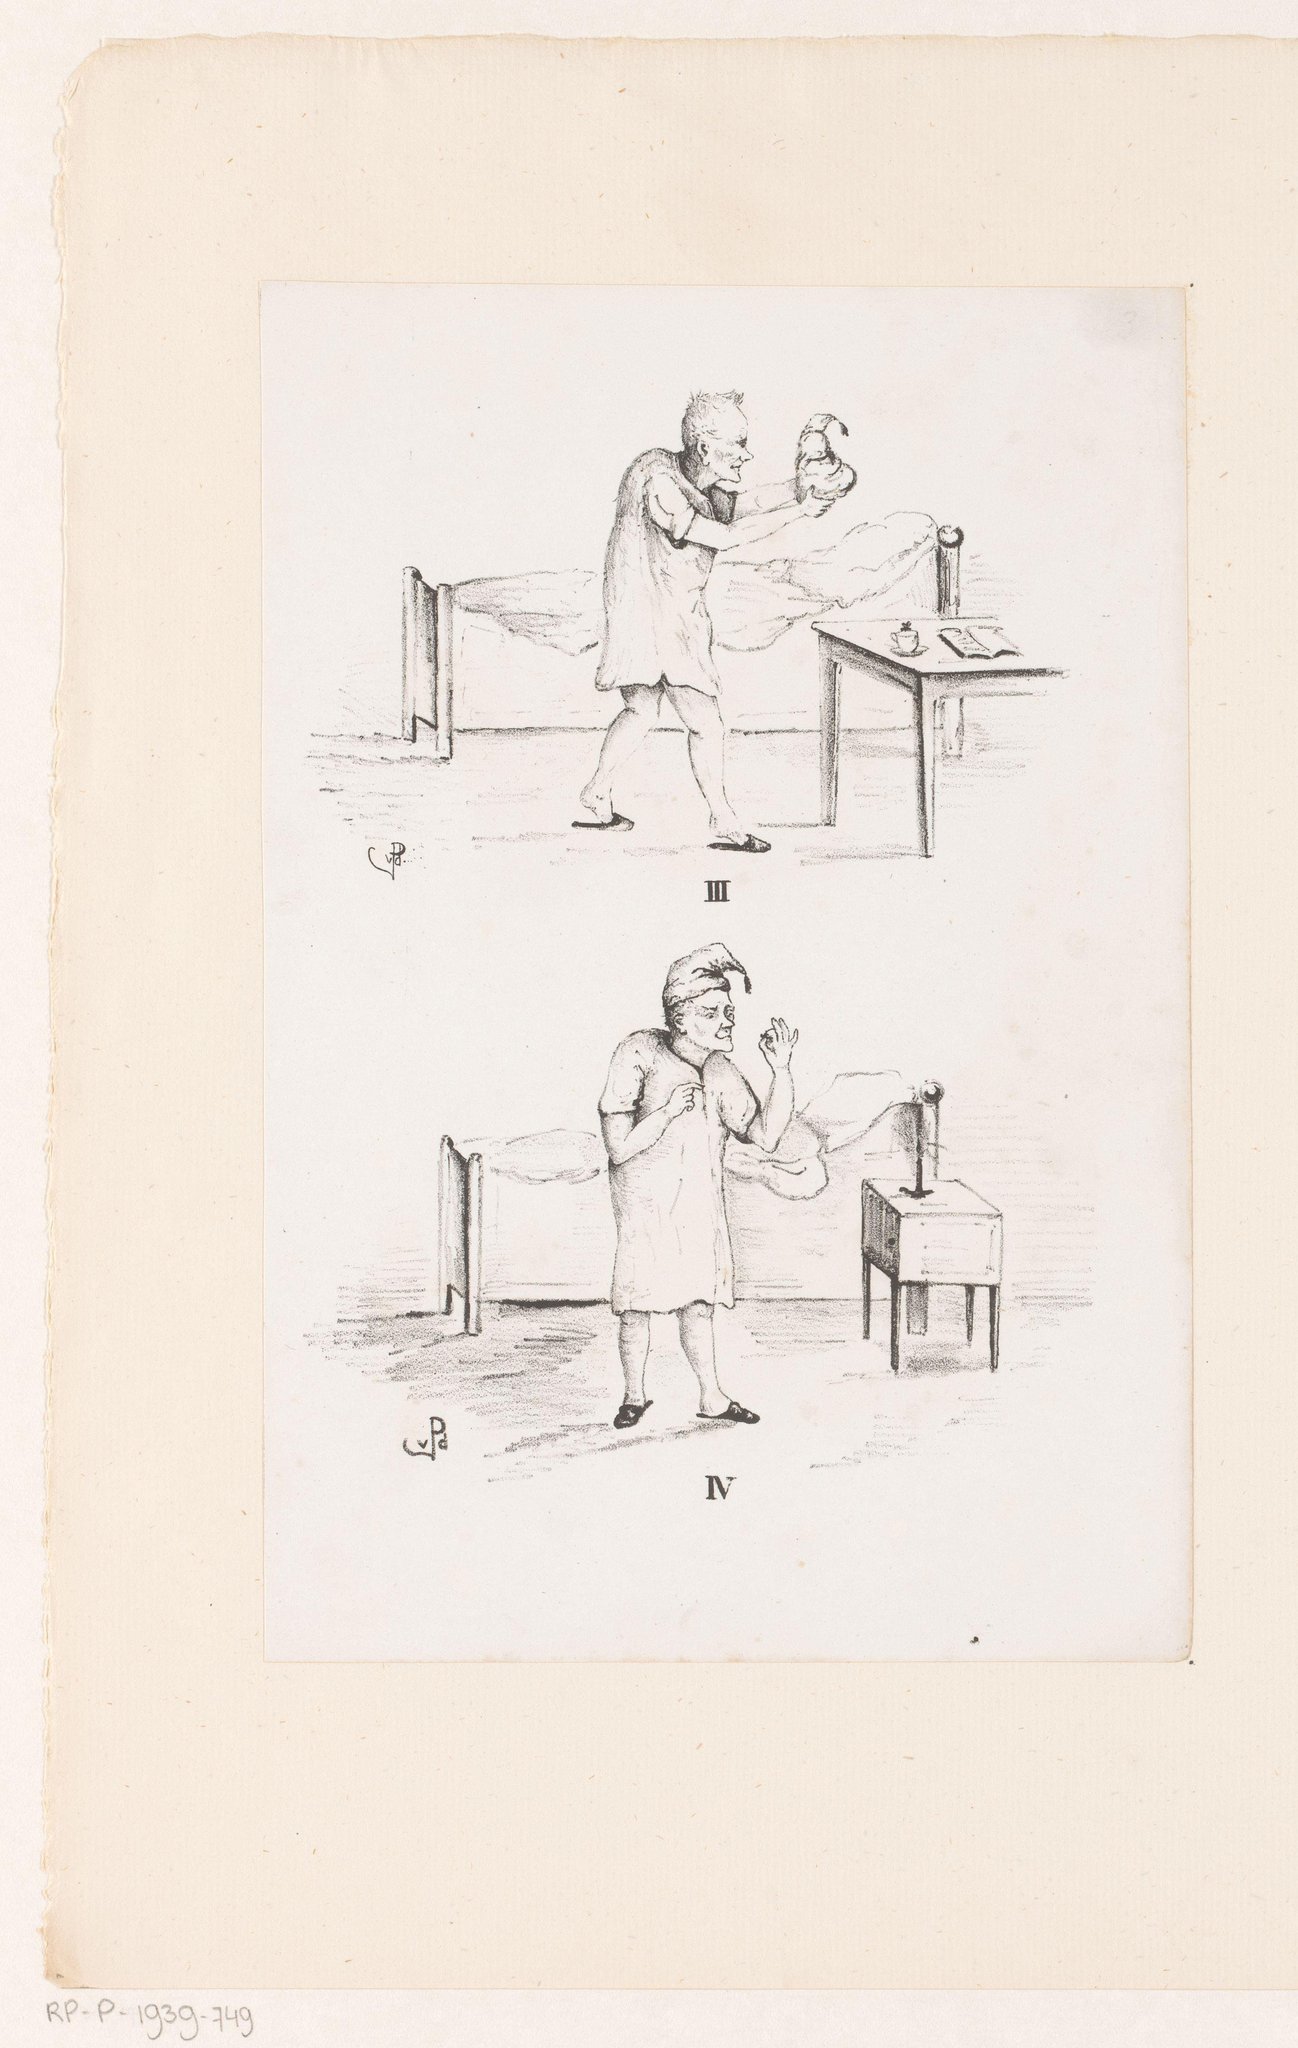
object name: print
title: Man ziet gevangen vlieg wegvliegen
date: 1864-1902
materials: paper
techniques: lithograph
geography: netherlands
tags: hunting, chase, insects: fly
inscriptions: collector's mark: Lugt 2760, collector's mark: Lugt 2166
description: Twee scènes op een blad. Een man kijkt verschrikt op als de door hem gevangen vlieg wegvliegt. Daaronder de zelfvoldane vlieg. Genummerd V en VI.